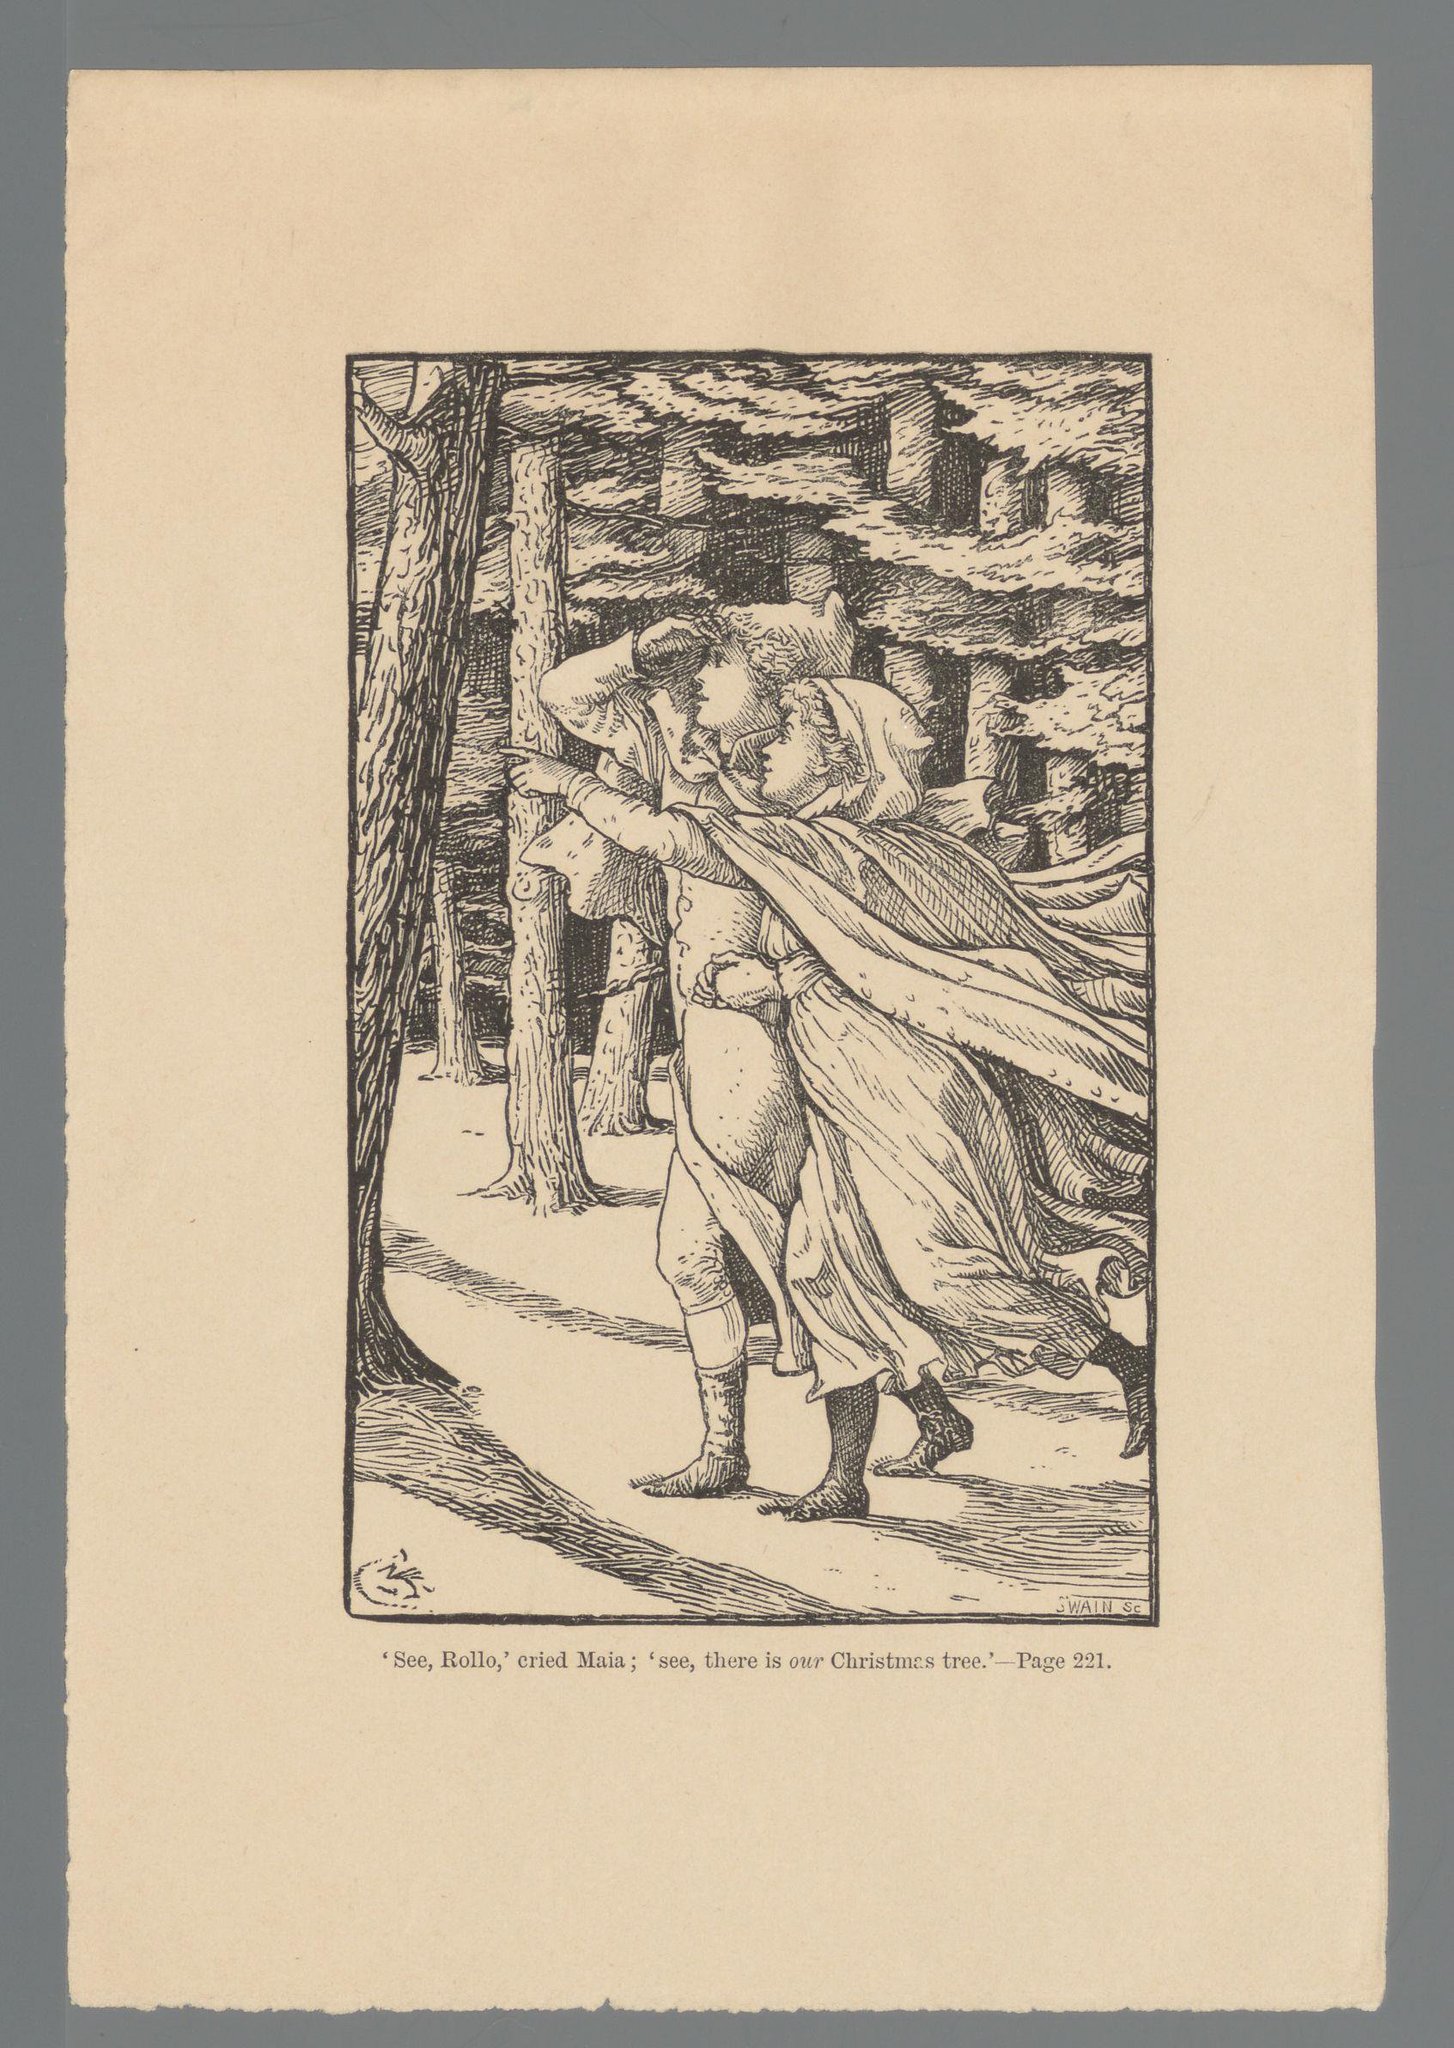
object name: book illustration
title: Rollo en Maia in een bos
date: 1884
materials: paper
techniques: letterpress printing, engraving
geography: london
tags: boy (child between toddler and youth), girl (child between toddler and youth), forest, wood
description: Prent uit: Molesworth, Mary Louisa. Christmas-Tree land. Londen: Macmillan & Co., 1884.